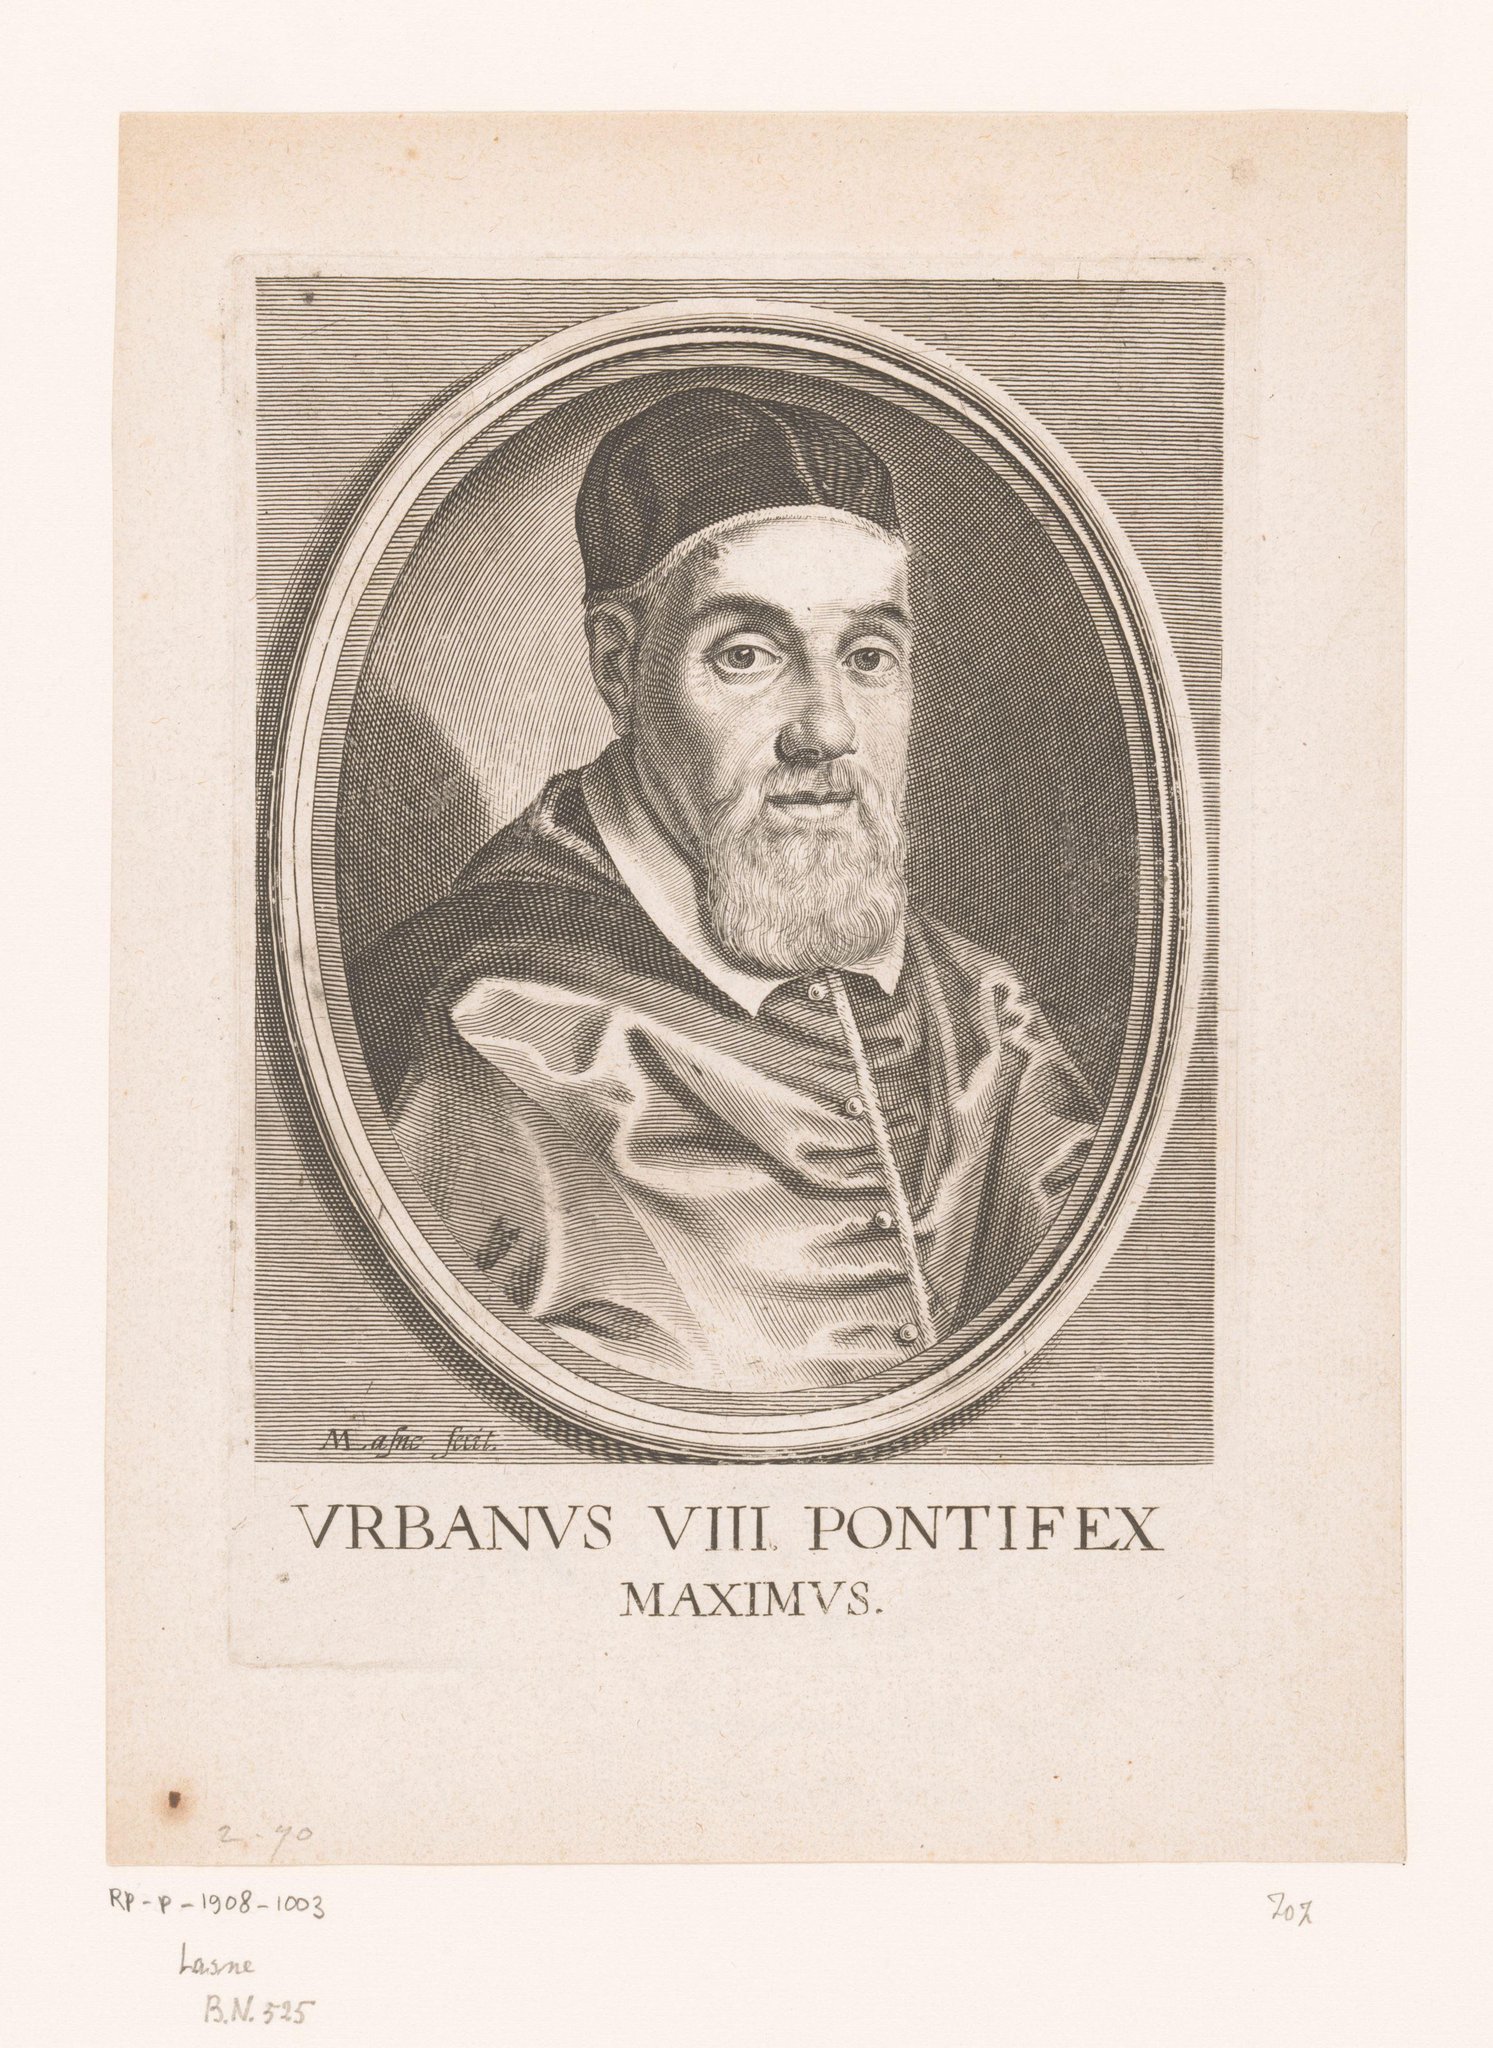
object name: print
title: Portret van Urbanus VIII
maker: michel lasne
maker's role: print maker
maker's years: 1590-1667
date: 1600-1667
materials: paper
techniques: engraving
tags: rome, clergyman, urbanus viii, historical persons, pope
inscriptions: collector's mark: Lugt 2228